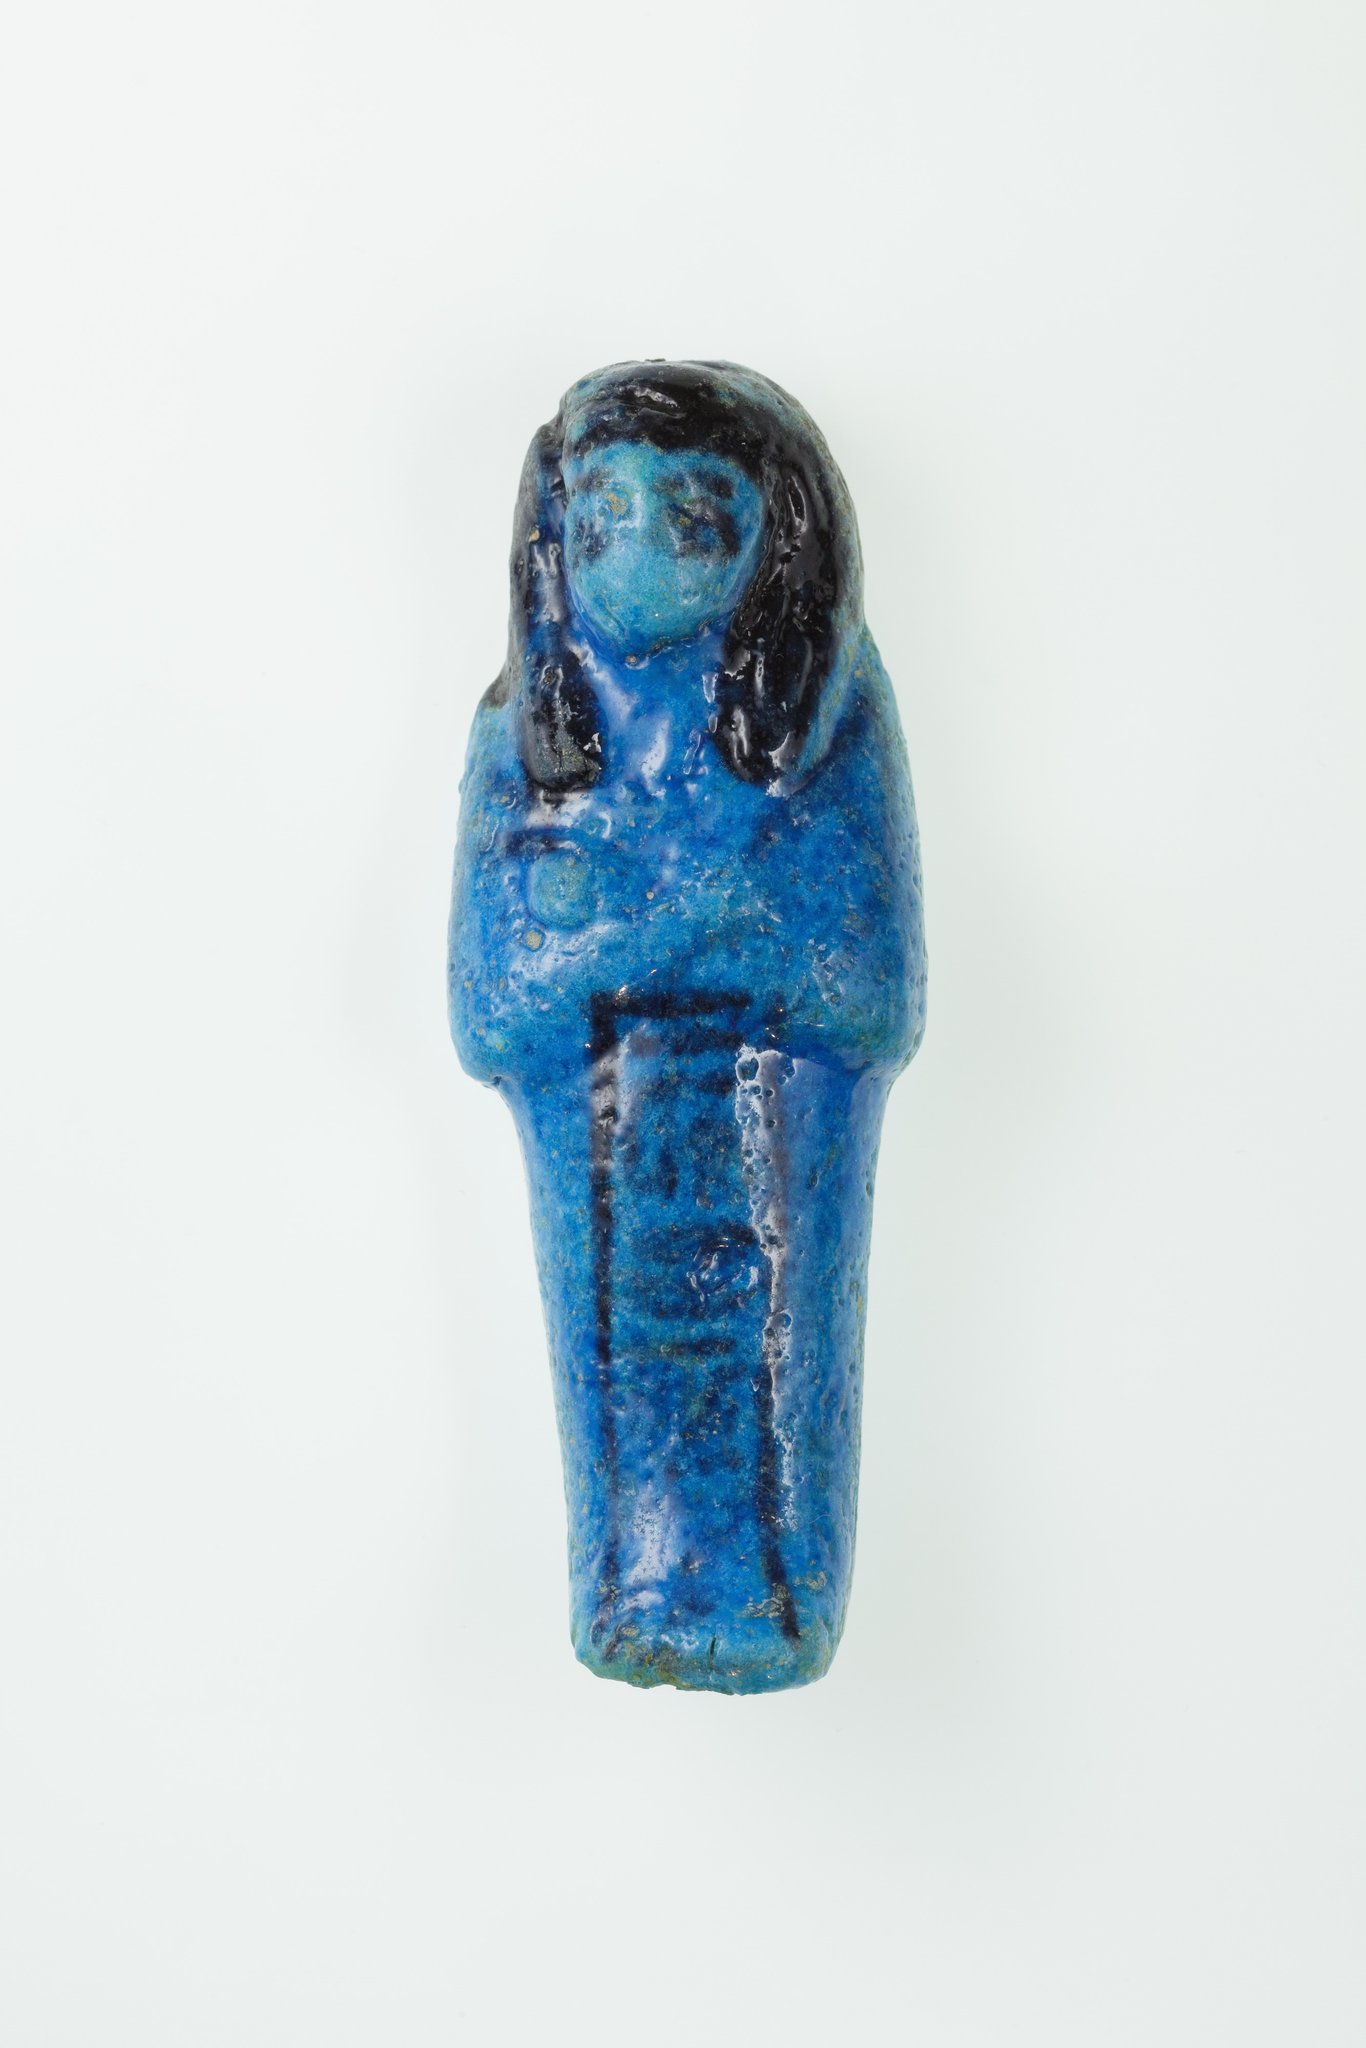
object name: shabti, worker, nauny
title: Worker Shabti of Nauny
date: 1050 BCE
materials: faience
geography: egypt